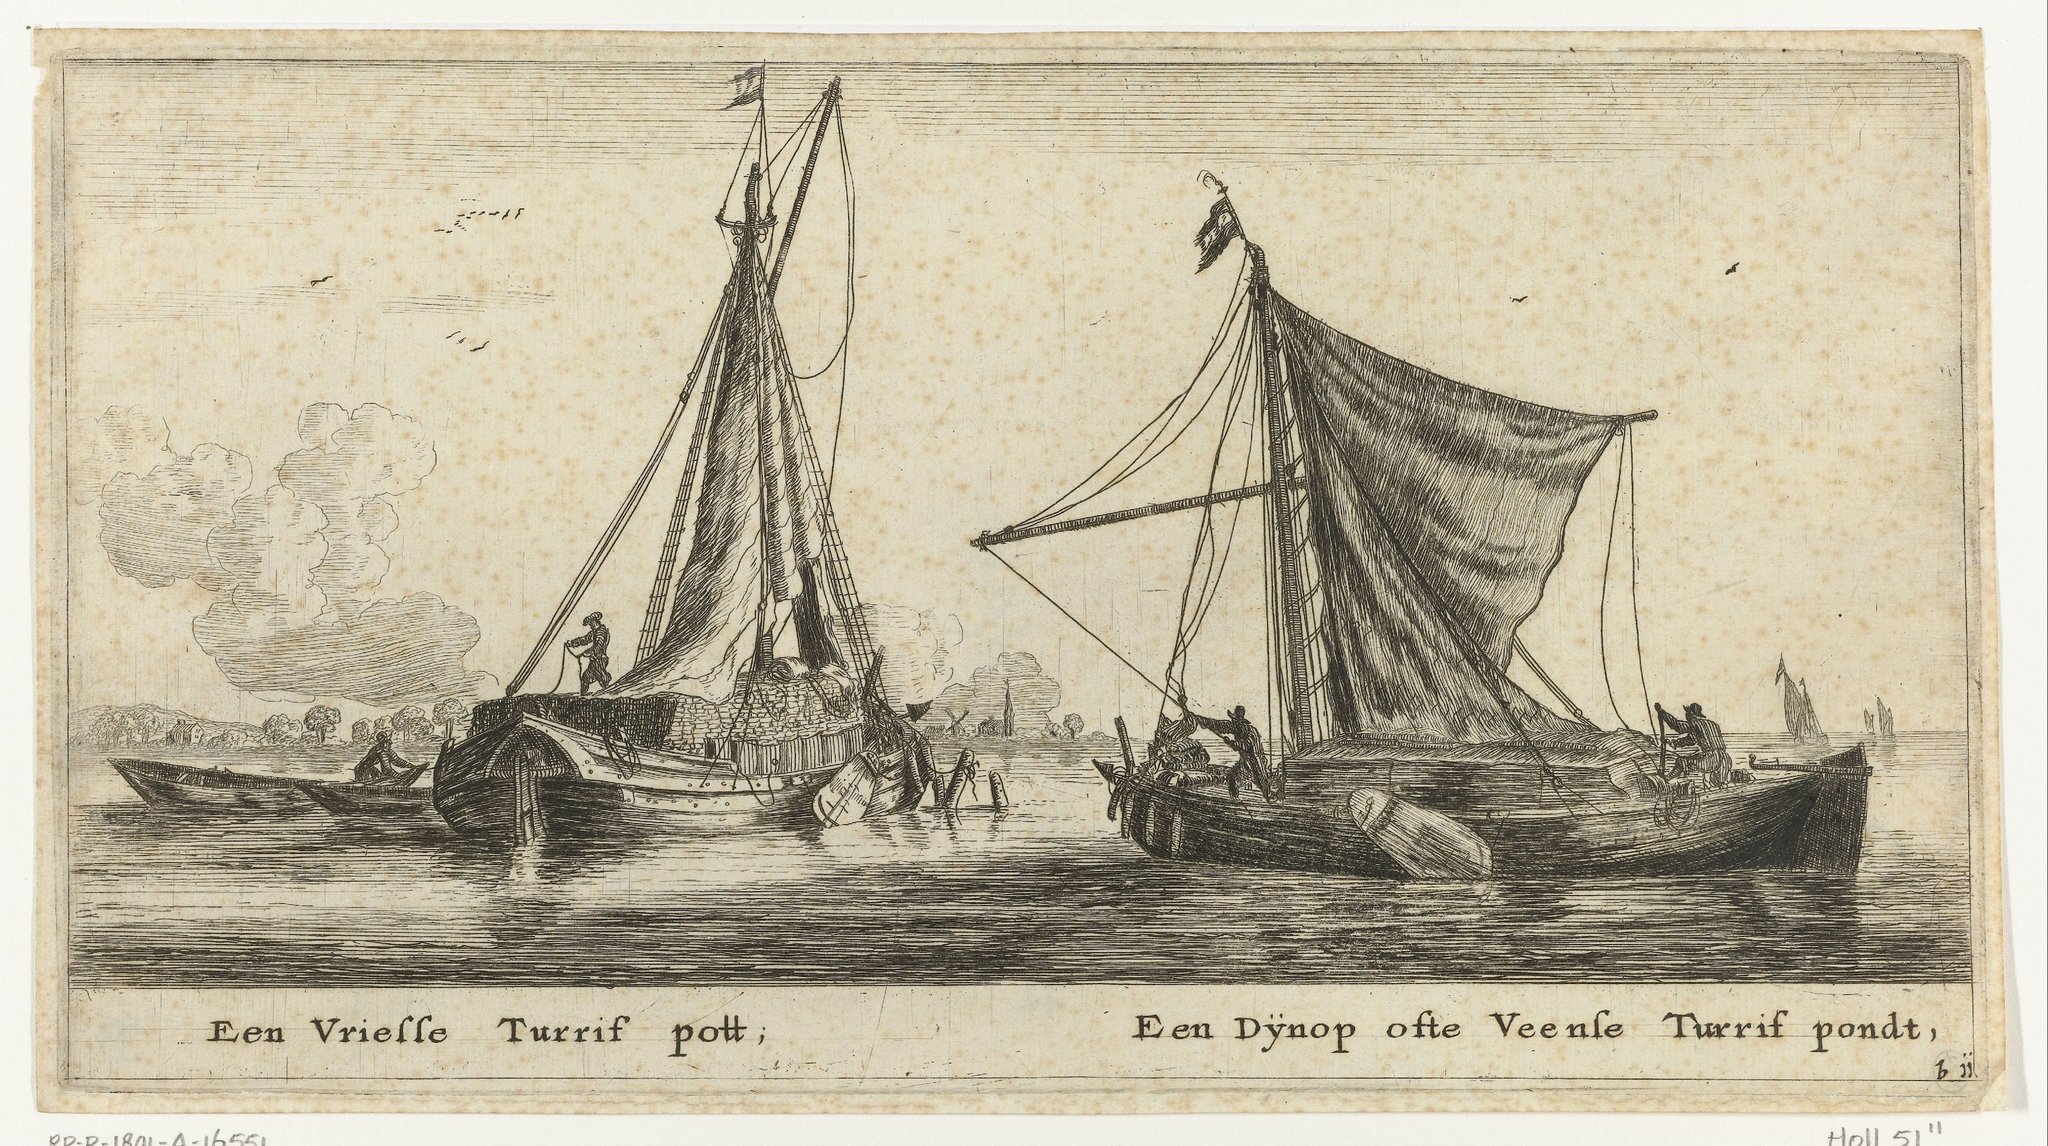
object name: print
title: Twee schepen: een Friese turfpont en een Dijnop schuit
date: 1652-1654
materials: paper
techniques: drypoint, etching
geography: netherlands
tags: ships (in general)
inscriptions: collector's mark: Lugt 1494, collector's mark: Lugt 2228, collector's mark: Lugt 462, collector's mark: Lugt 1227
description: Een Friese turfpont en een dijnop of Veense turfpont, beide schepen geladen met turf.